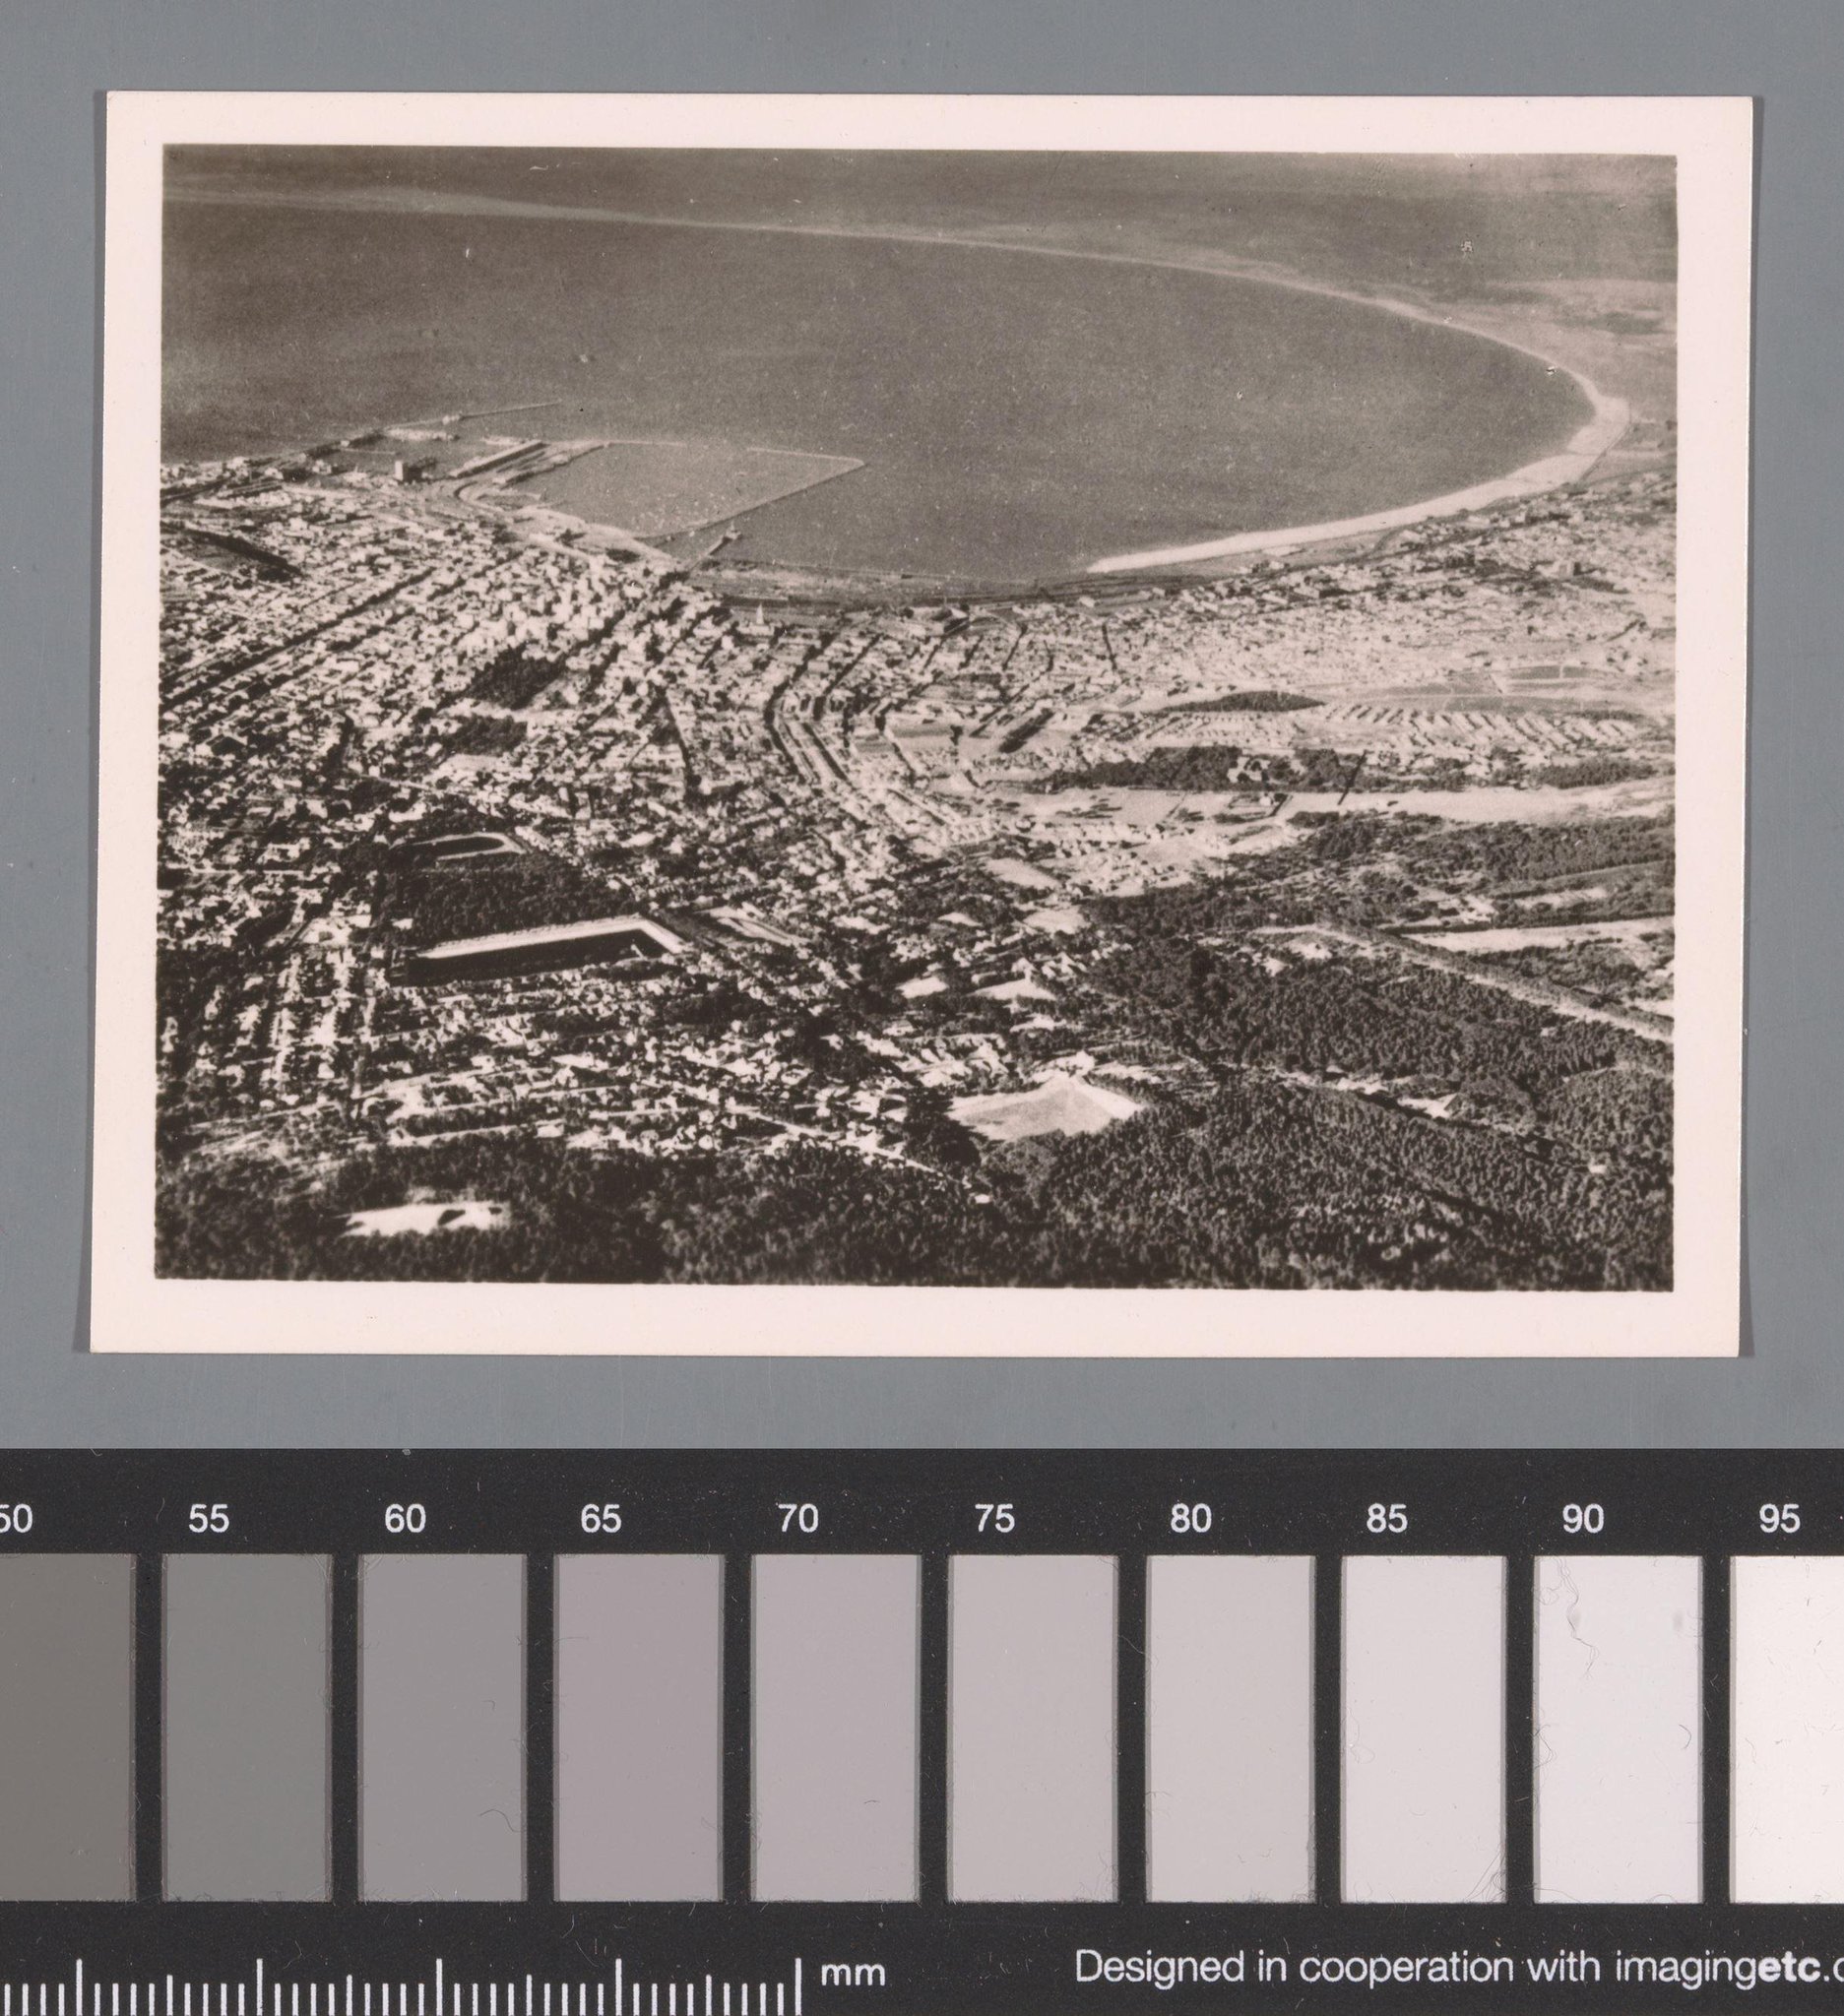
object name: photograph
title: Gezicht op de Tafelbaai vanaf de Tafelberg in Kaapstad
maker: blackshaw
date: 1940-1960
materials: photographic support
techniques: gelatin silver print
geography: south africa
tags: gulf, bay